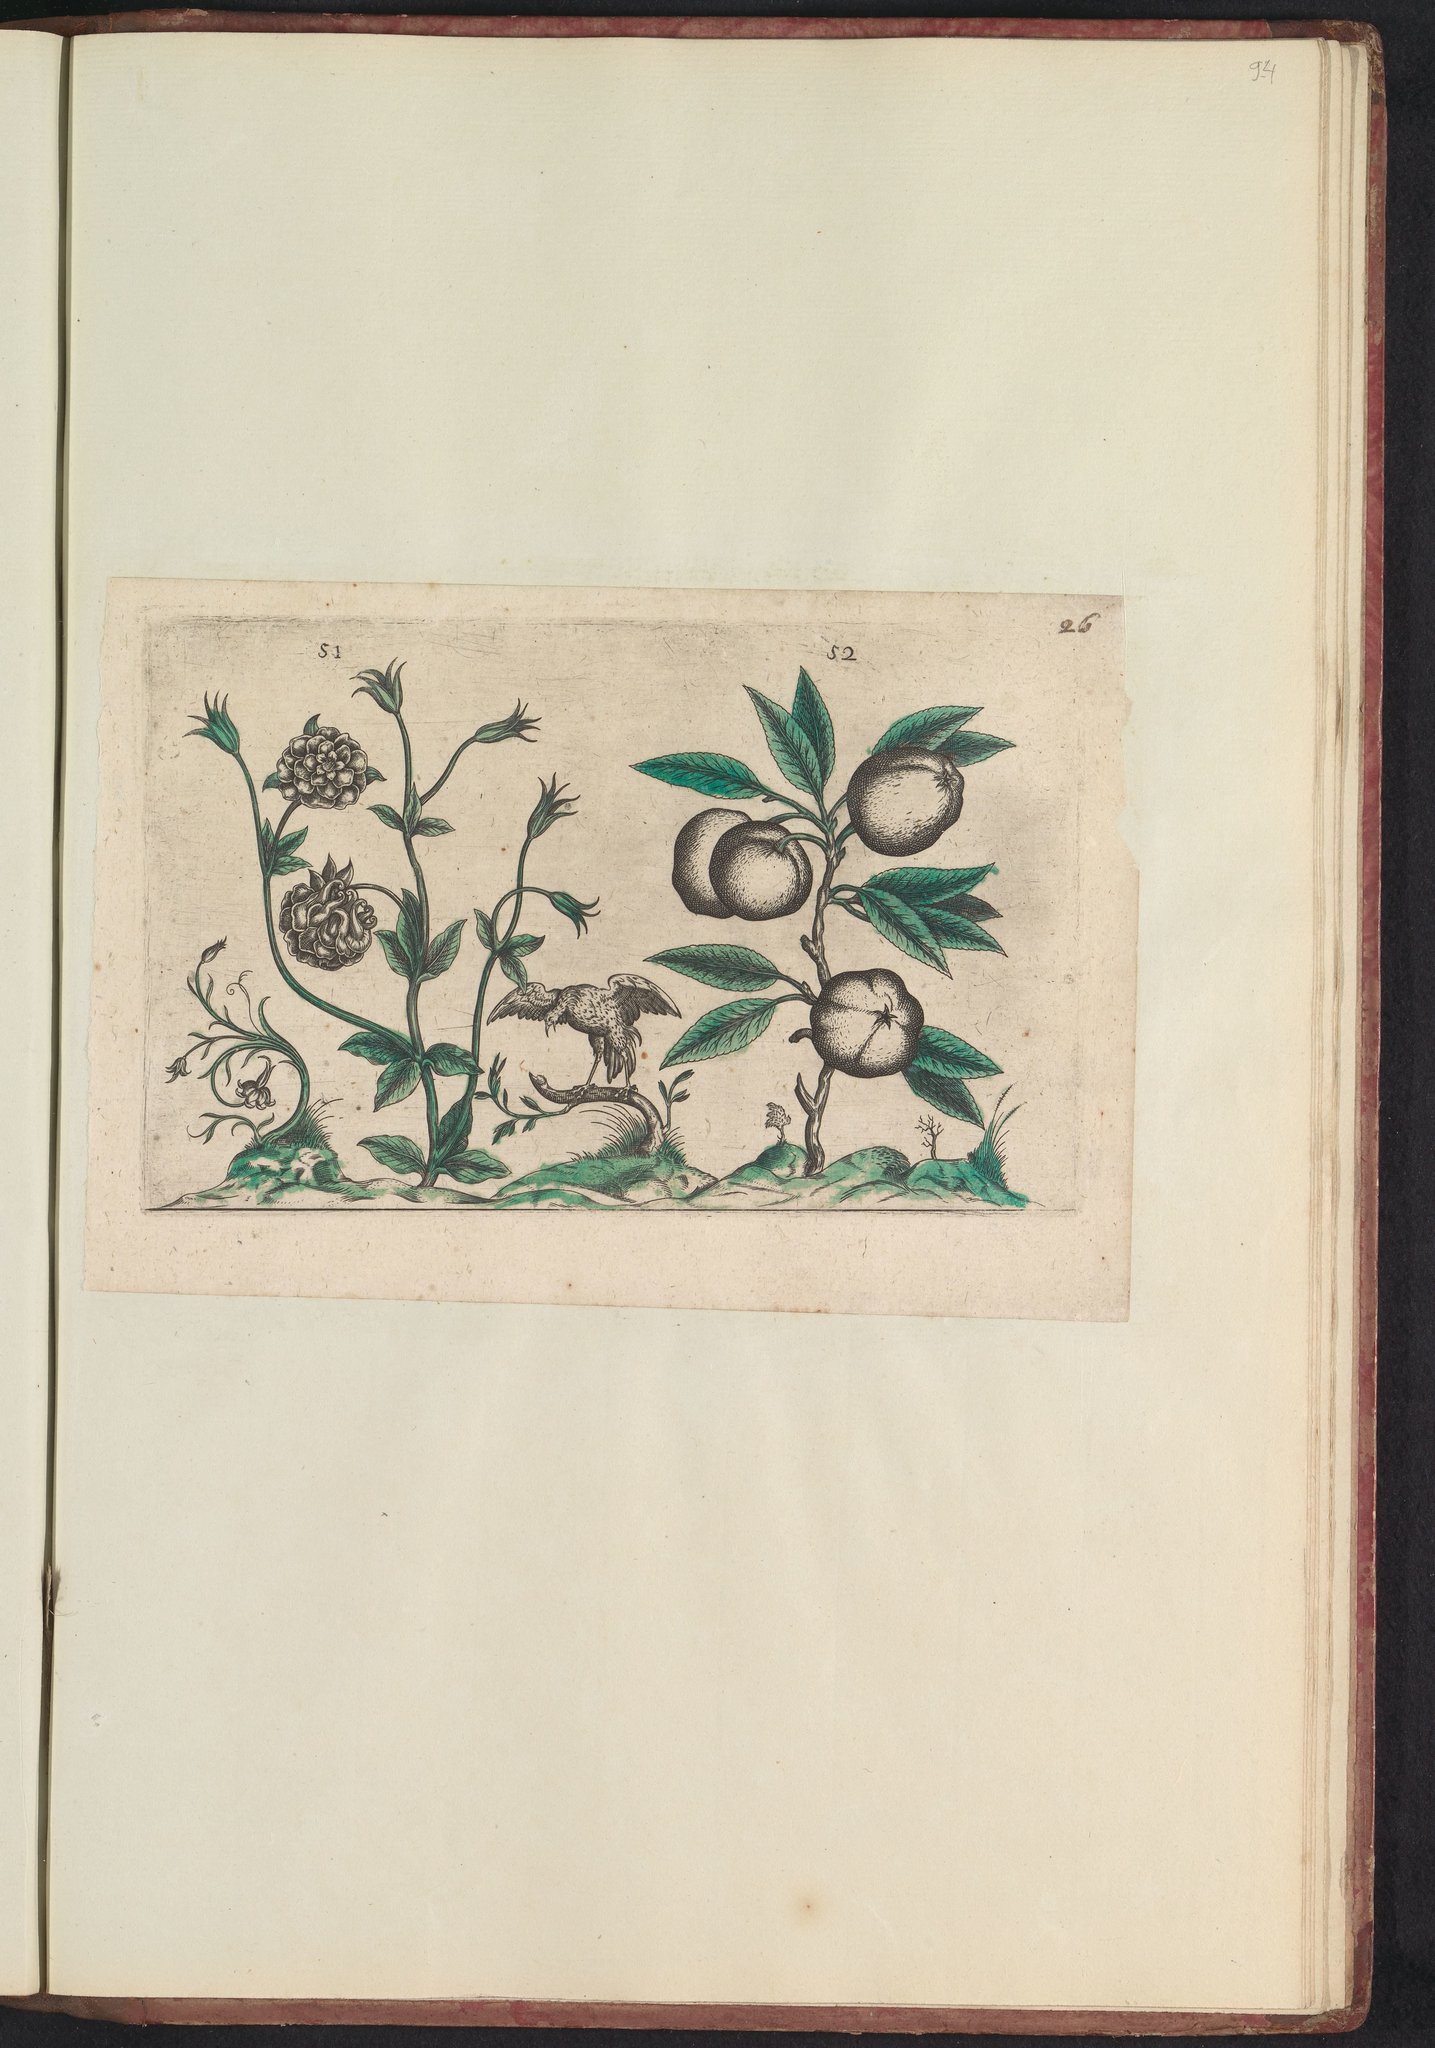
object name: print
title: Dubbele akelei (Aquilegia vulgaris) en appel (Malus pumila)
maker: Anonymous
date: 1604-1632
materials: ink, paper, watercolor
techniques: engraving, hand coloring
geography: cologne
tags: fruits: apple, flowers: columbine, birds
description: Dubbele akelei en appel. Met een vogel en enkele ornamentele planten. Figs. 51 en 52 op een blad met de hand genummerd 26. In: Anselmi Boëtii de Boot I.C. Brugensis & Rodolphi II. Imp. Roman. medici a cubiculis Florum, Herbarum, ac fructuum selectiorum icones, & vires pleraeque hactenus ignotæ. Onderdeel van het album met bladen en platen uit De Boodts herbarium van 1640. Het twaalfde van twaalf albums met aquarellen van dieren, vogels en planten bekend rond 1600, gemaakt in opdracht van keizer Rudolf II.